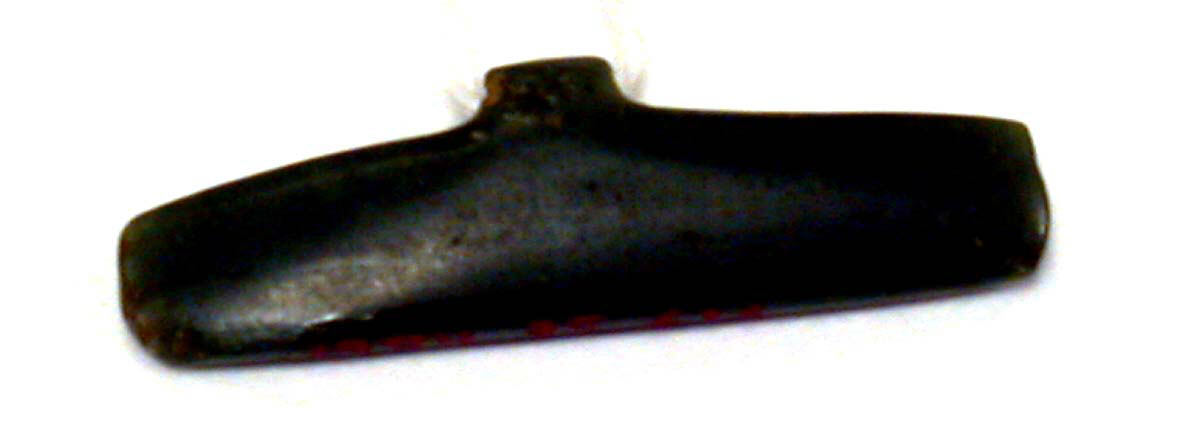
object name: pendant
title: Winged Pendant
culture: tairona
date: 1501-1600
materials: stone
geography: colombia